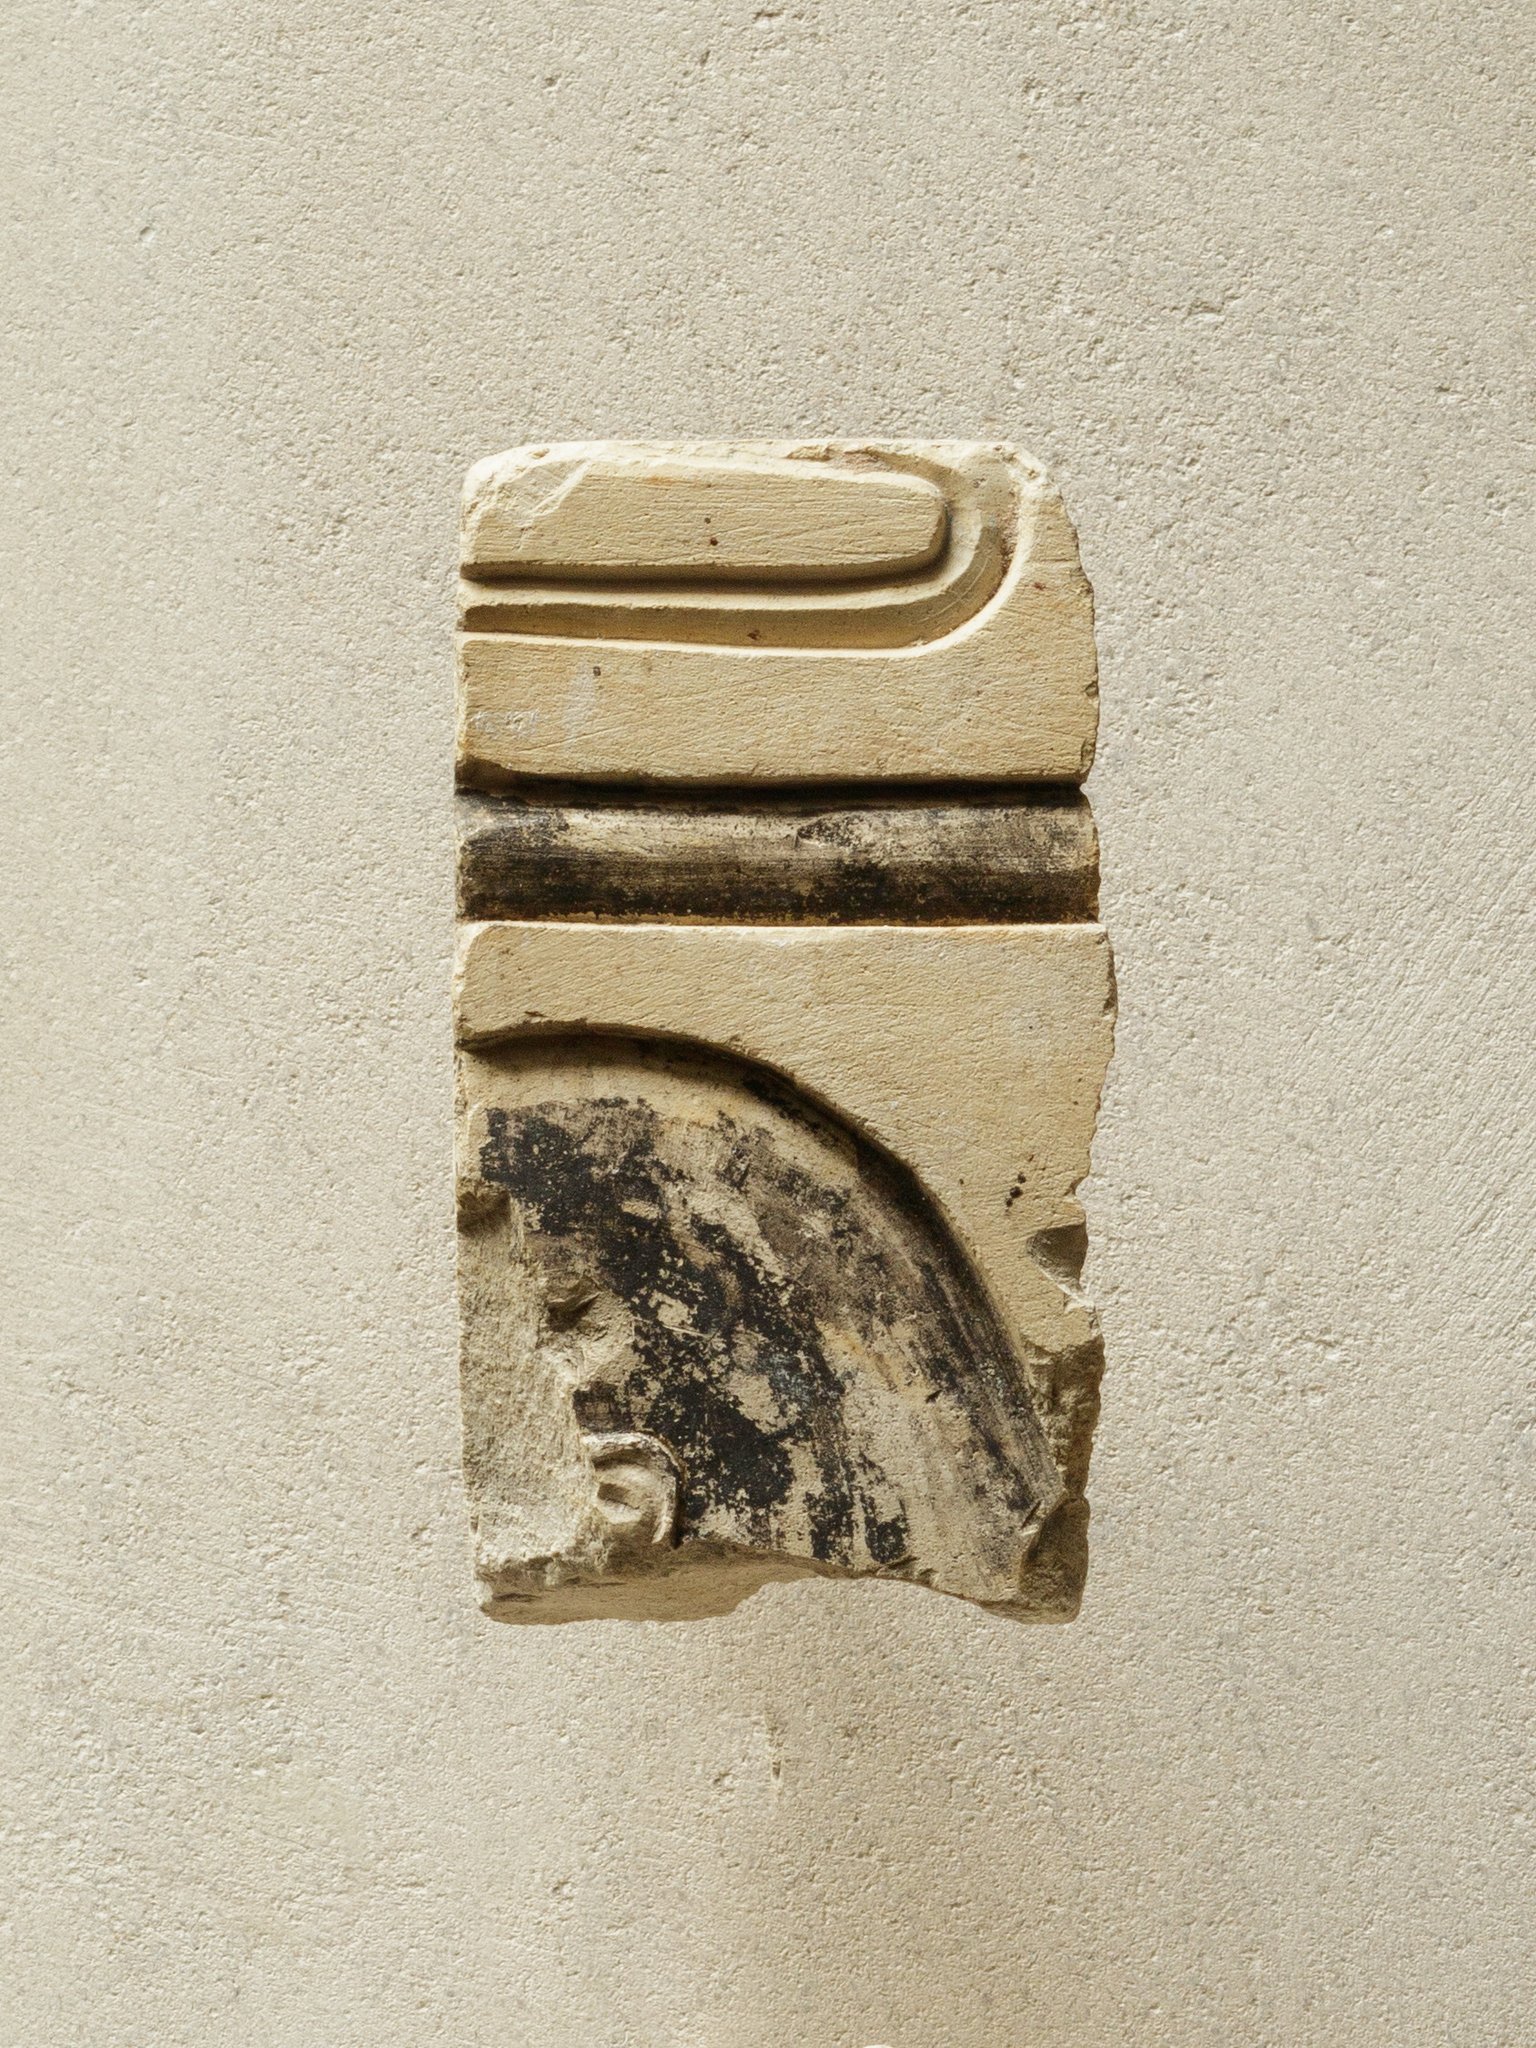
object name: relief fragment, tomb of neferu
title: Relief fragment from a procession of attendants - see 31.3.1-1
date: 2051-2030 BCE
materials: limestone, paint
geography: egypt